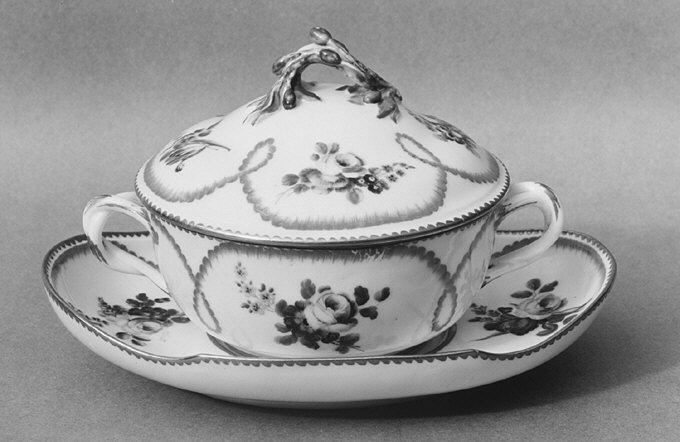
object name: bowl with cover and tray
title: Bowl with cover (écuelle) and tray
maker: sèvres manufactory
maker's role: manufactory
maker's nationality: french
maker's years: 1740-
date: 1764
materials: soft paste porcelain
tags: roses